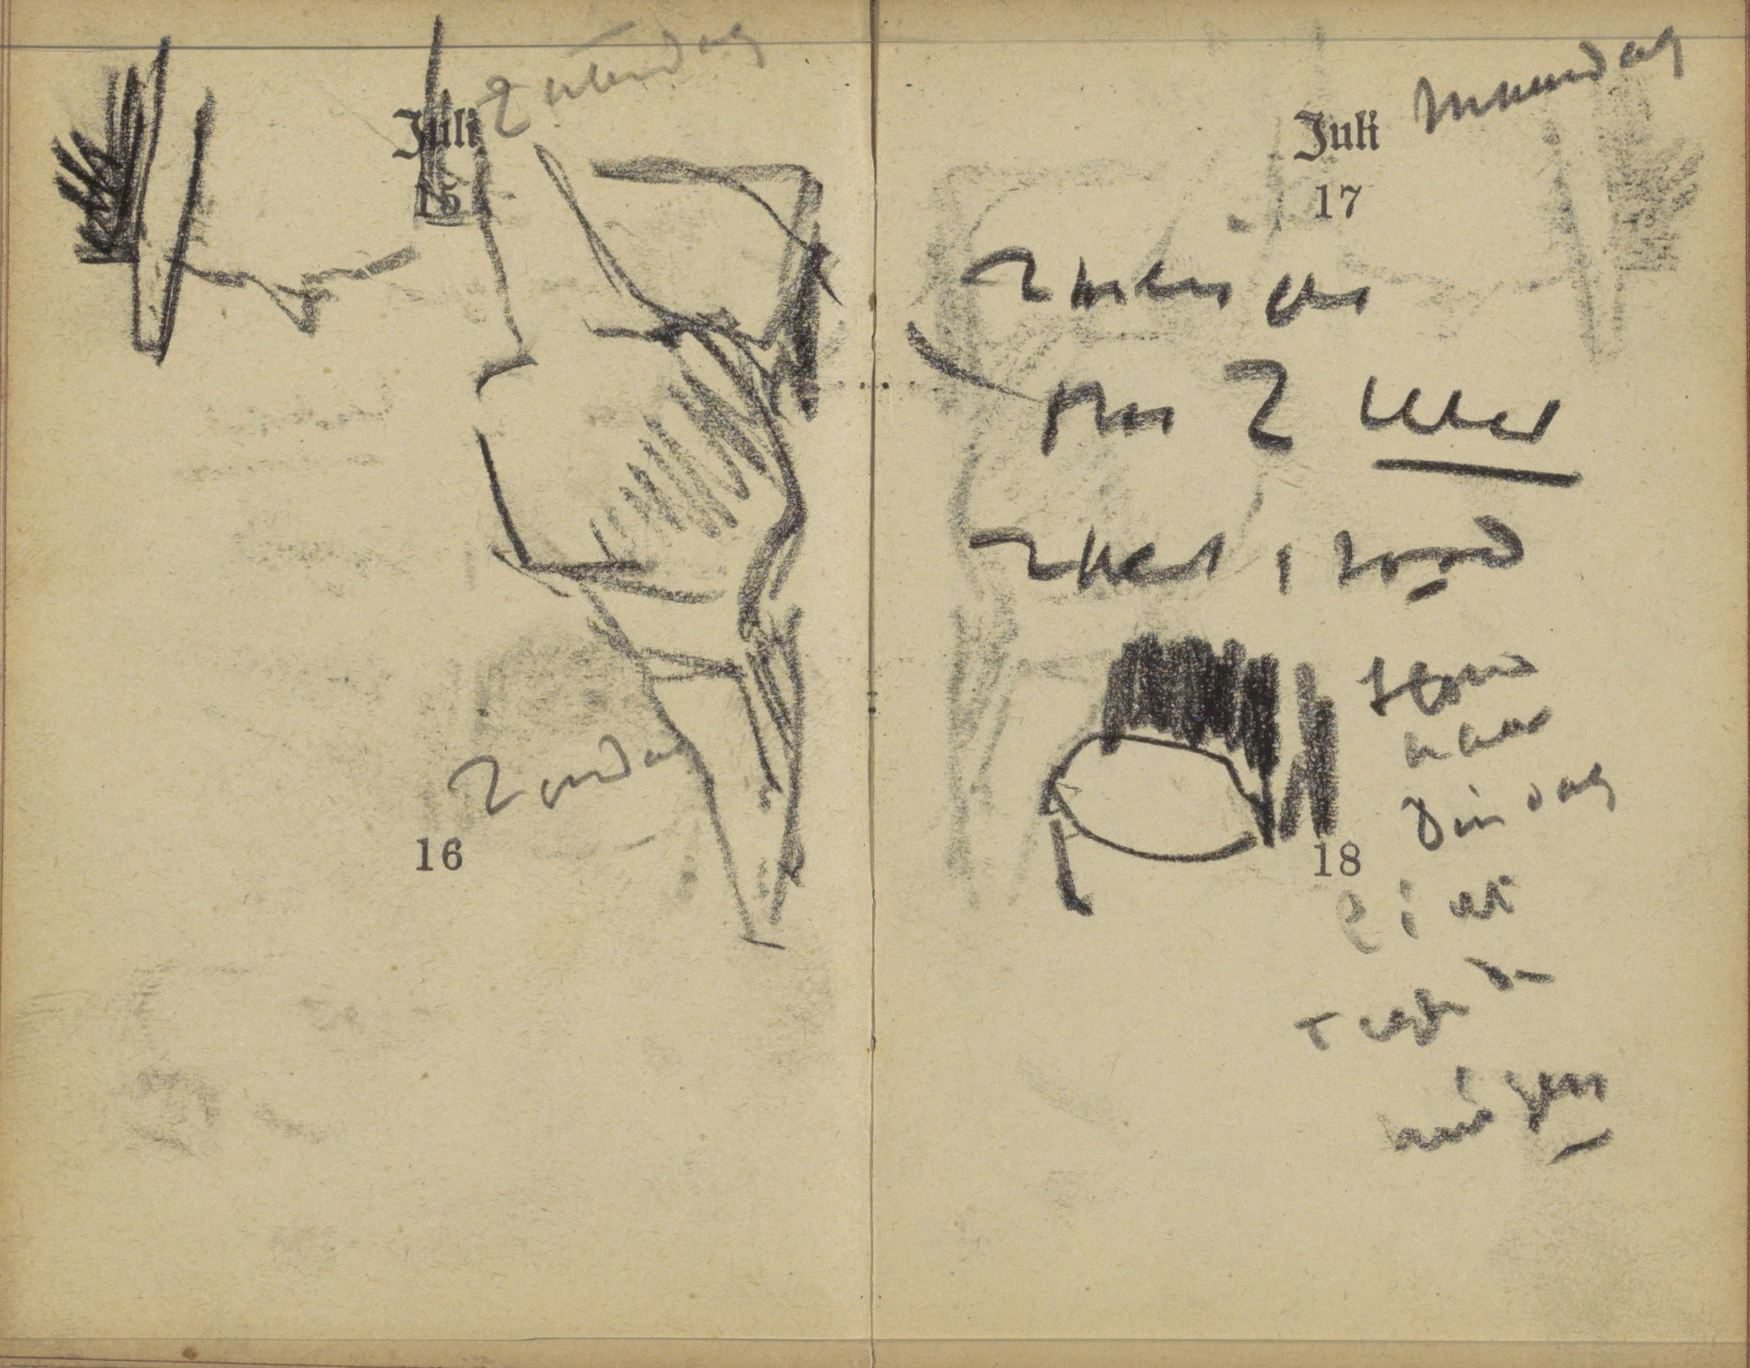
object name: sketchbook leaf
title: Vrouw met hoed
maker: george hendrik breitner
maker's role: draughtsman, painter, print maker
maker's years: 1857-1923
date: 1893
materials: chalk, paper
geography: amsterdam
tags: hand-cart, adult woman, head-gear: hat (+ women's clothes), dog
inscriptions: annotation: ‘[...] om 2 uur/ [...] 1 rood/ Hond in kar/ licht/ Tegen de/ huizen’, annotation: ‘Zaterdag/ Zondag/ Maandag/ Dinsdag’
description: Rechts mogelijk een studie van een hond in een kar. Pagina 83 en pagina 84 uit een als schetsboek gebruikte agenda met 80 bladen.